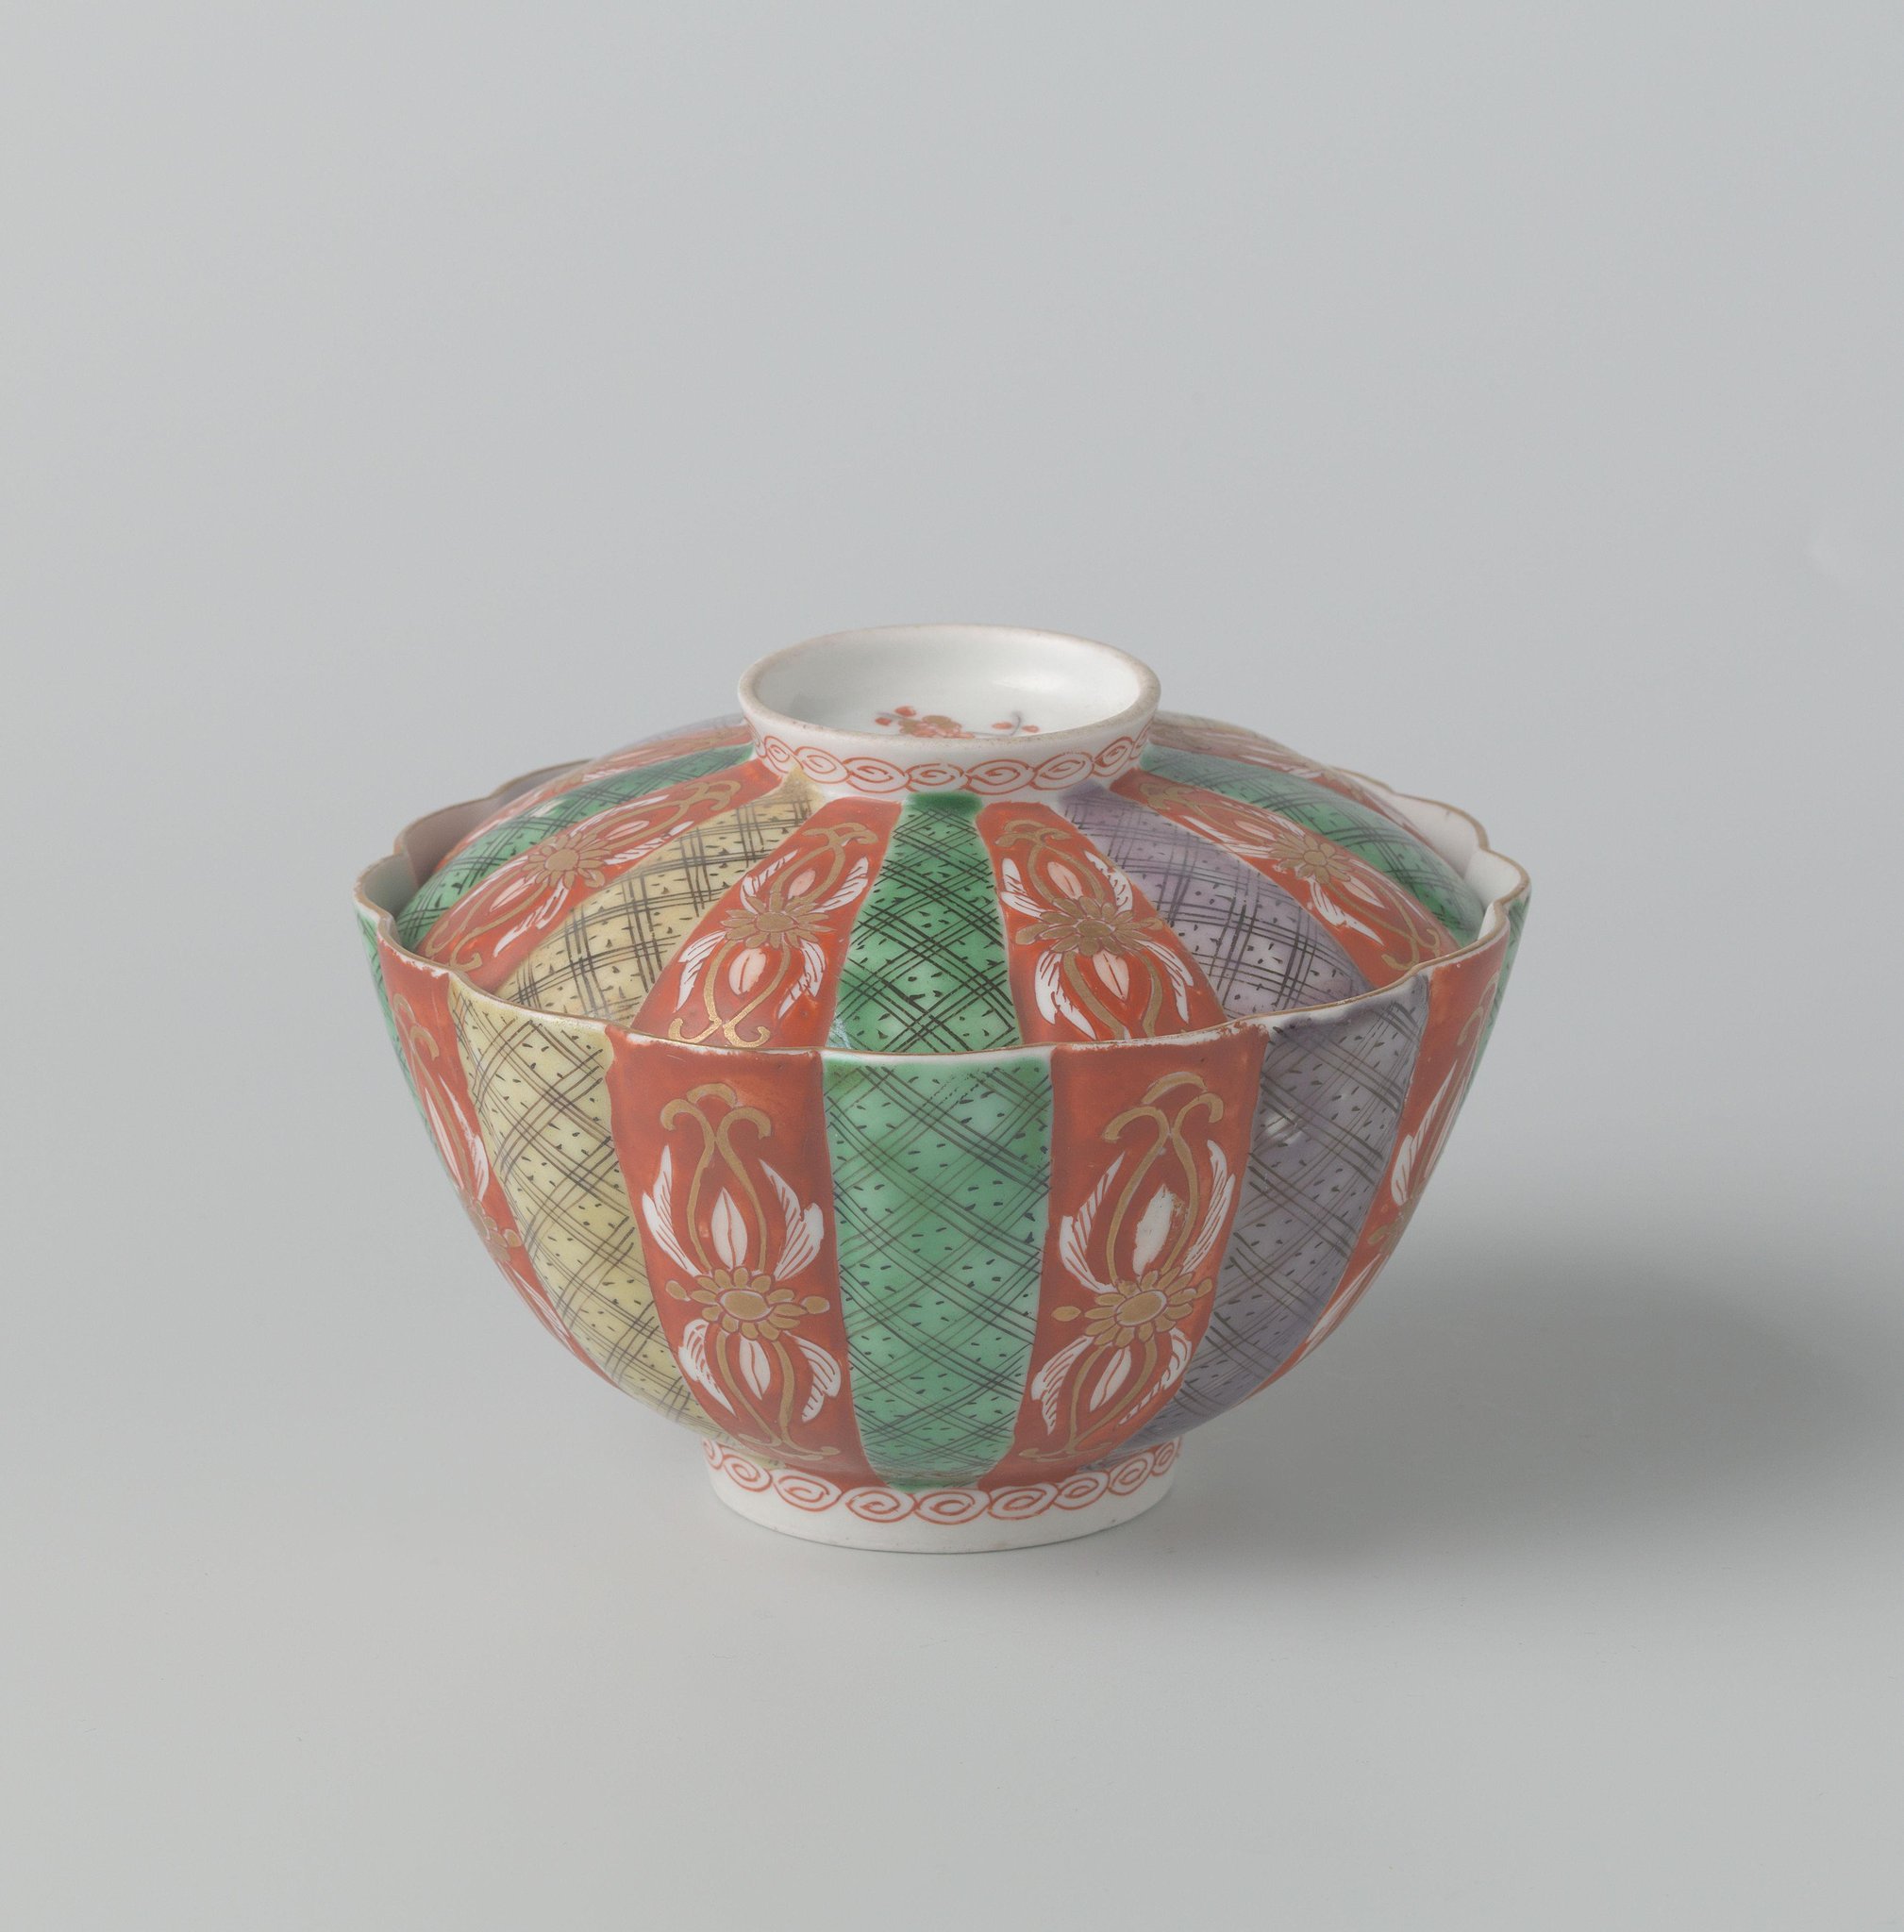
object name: covered bowl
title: Covered bowl with scrolls, diaper pattern and scattered flowers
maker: Anonymous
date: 1700-1749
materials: glaze, gold, porcelain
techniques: firing, gilding, turning, vitrification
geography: japan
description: Kom met deksel, met geribde wand en rand. Beschilderd in emailkleuren met velden met geometrische patronen en ranken tegen een rode, groene, gele en aubergine-kleurige achtergrond. Aan de binne zijde gestileerde chrysanten.